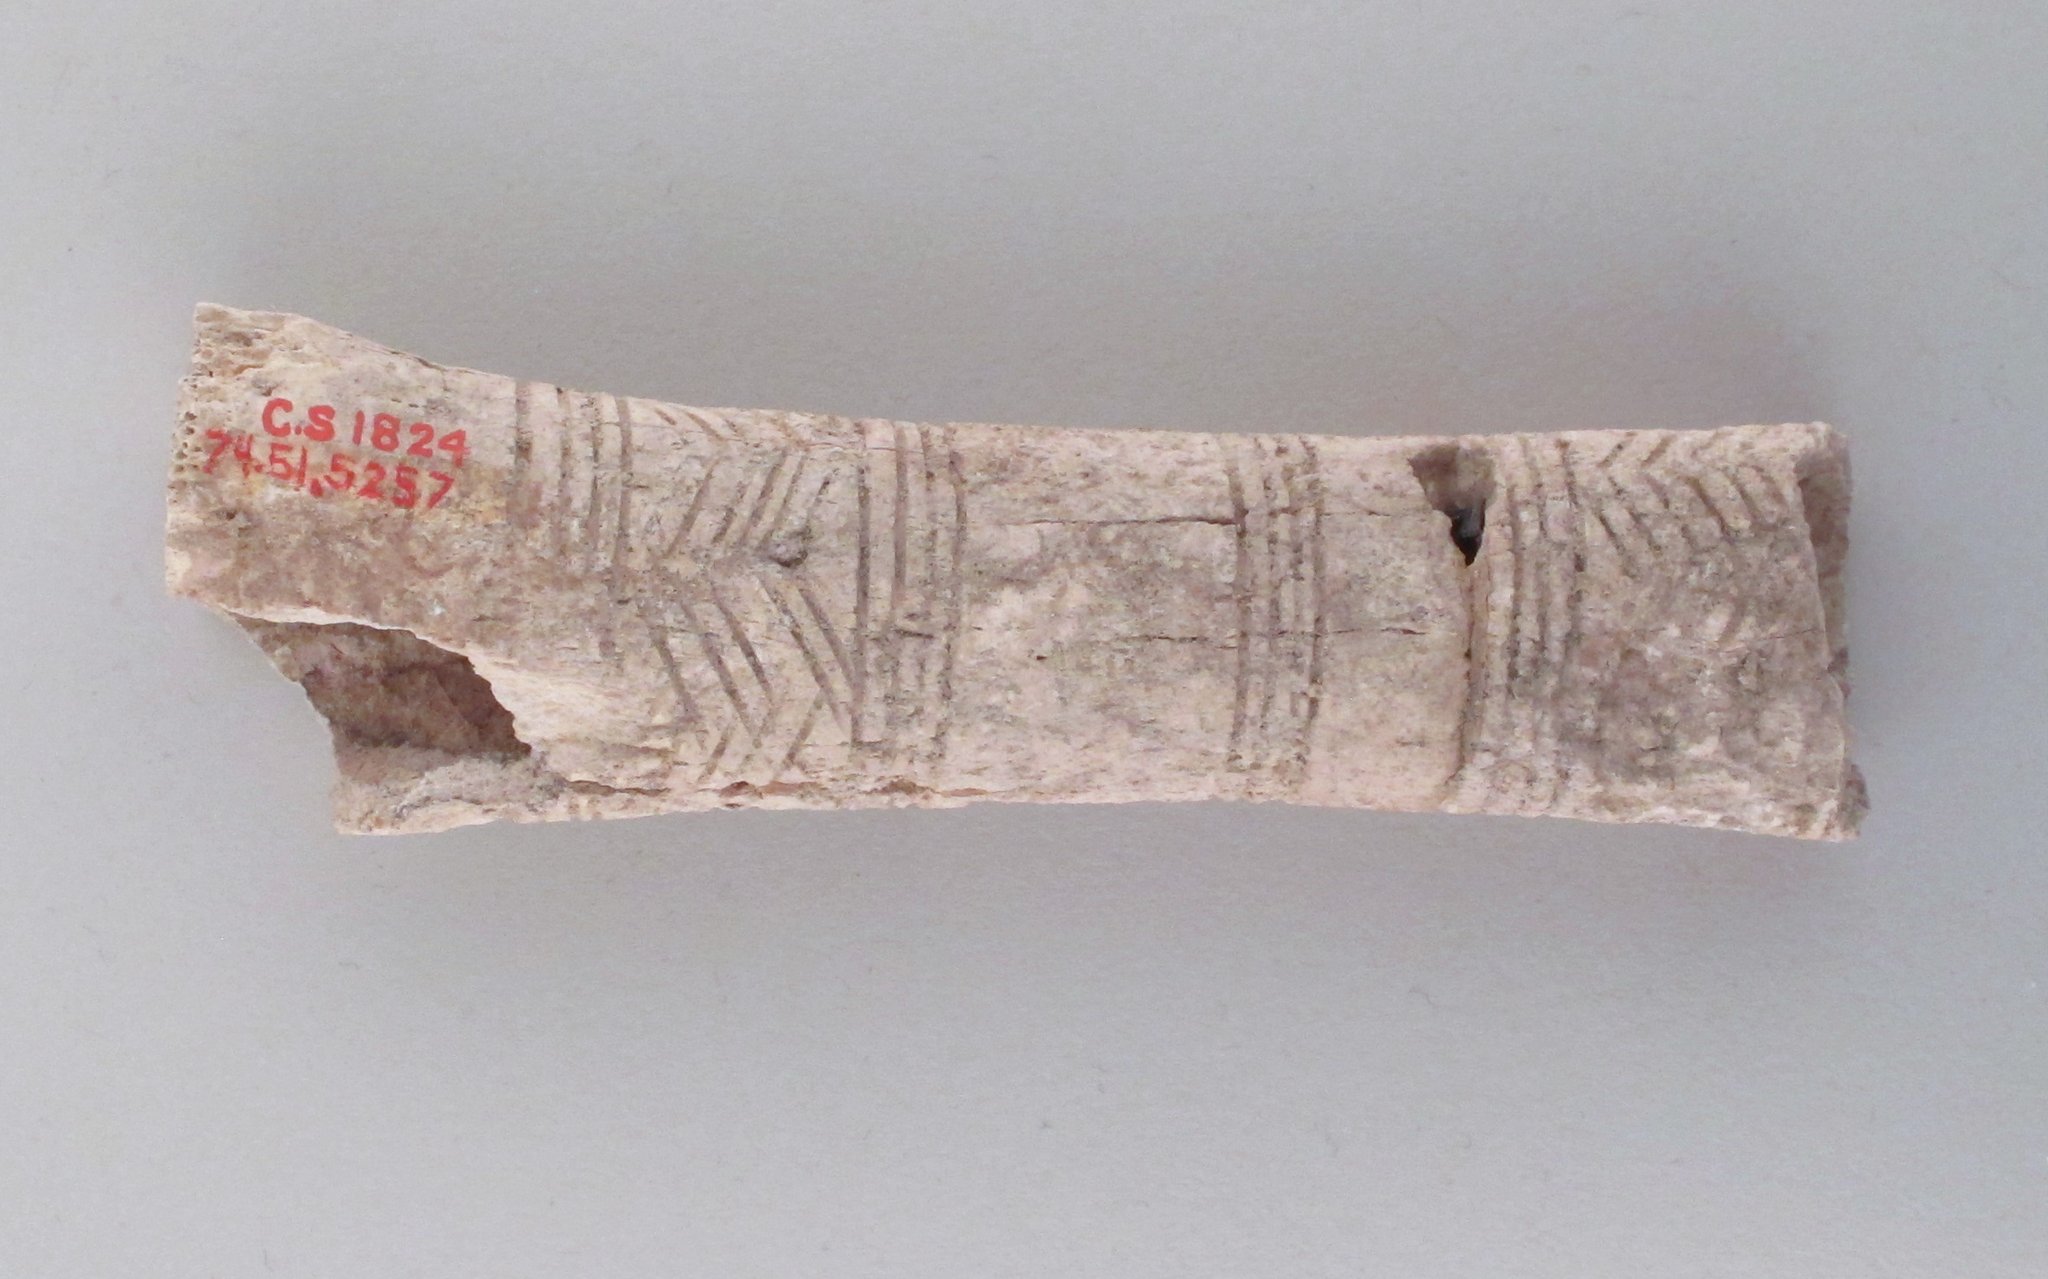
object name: handle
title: Bone handle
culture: cypriot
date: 3900 BCE-100 CE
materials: bone